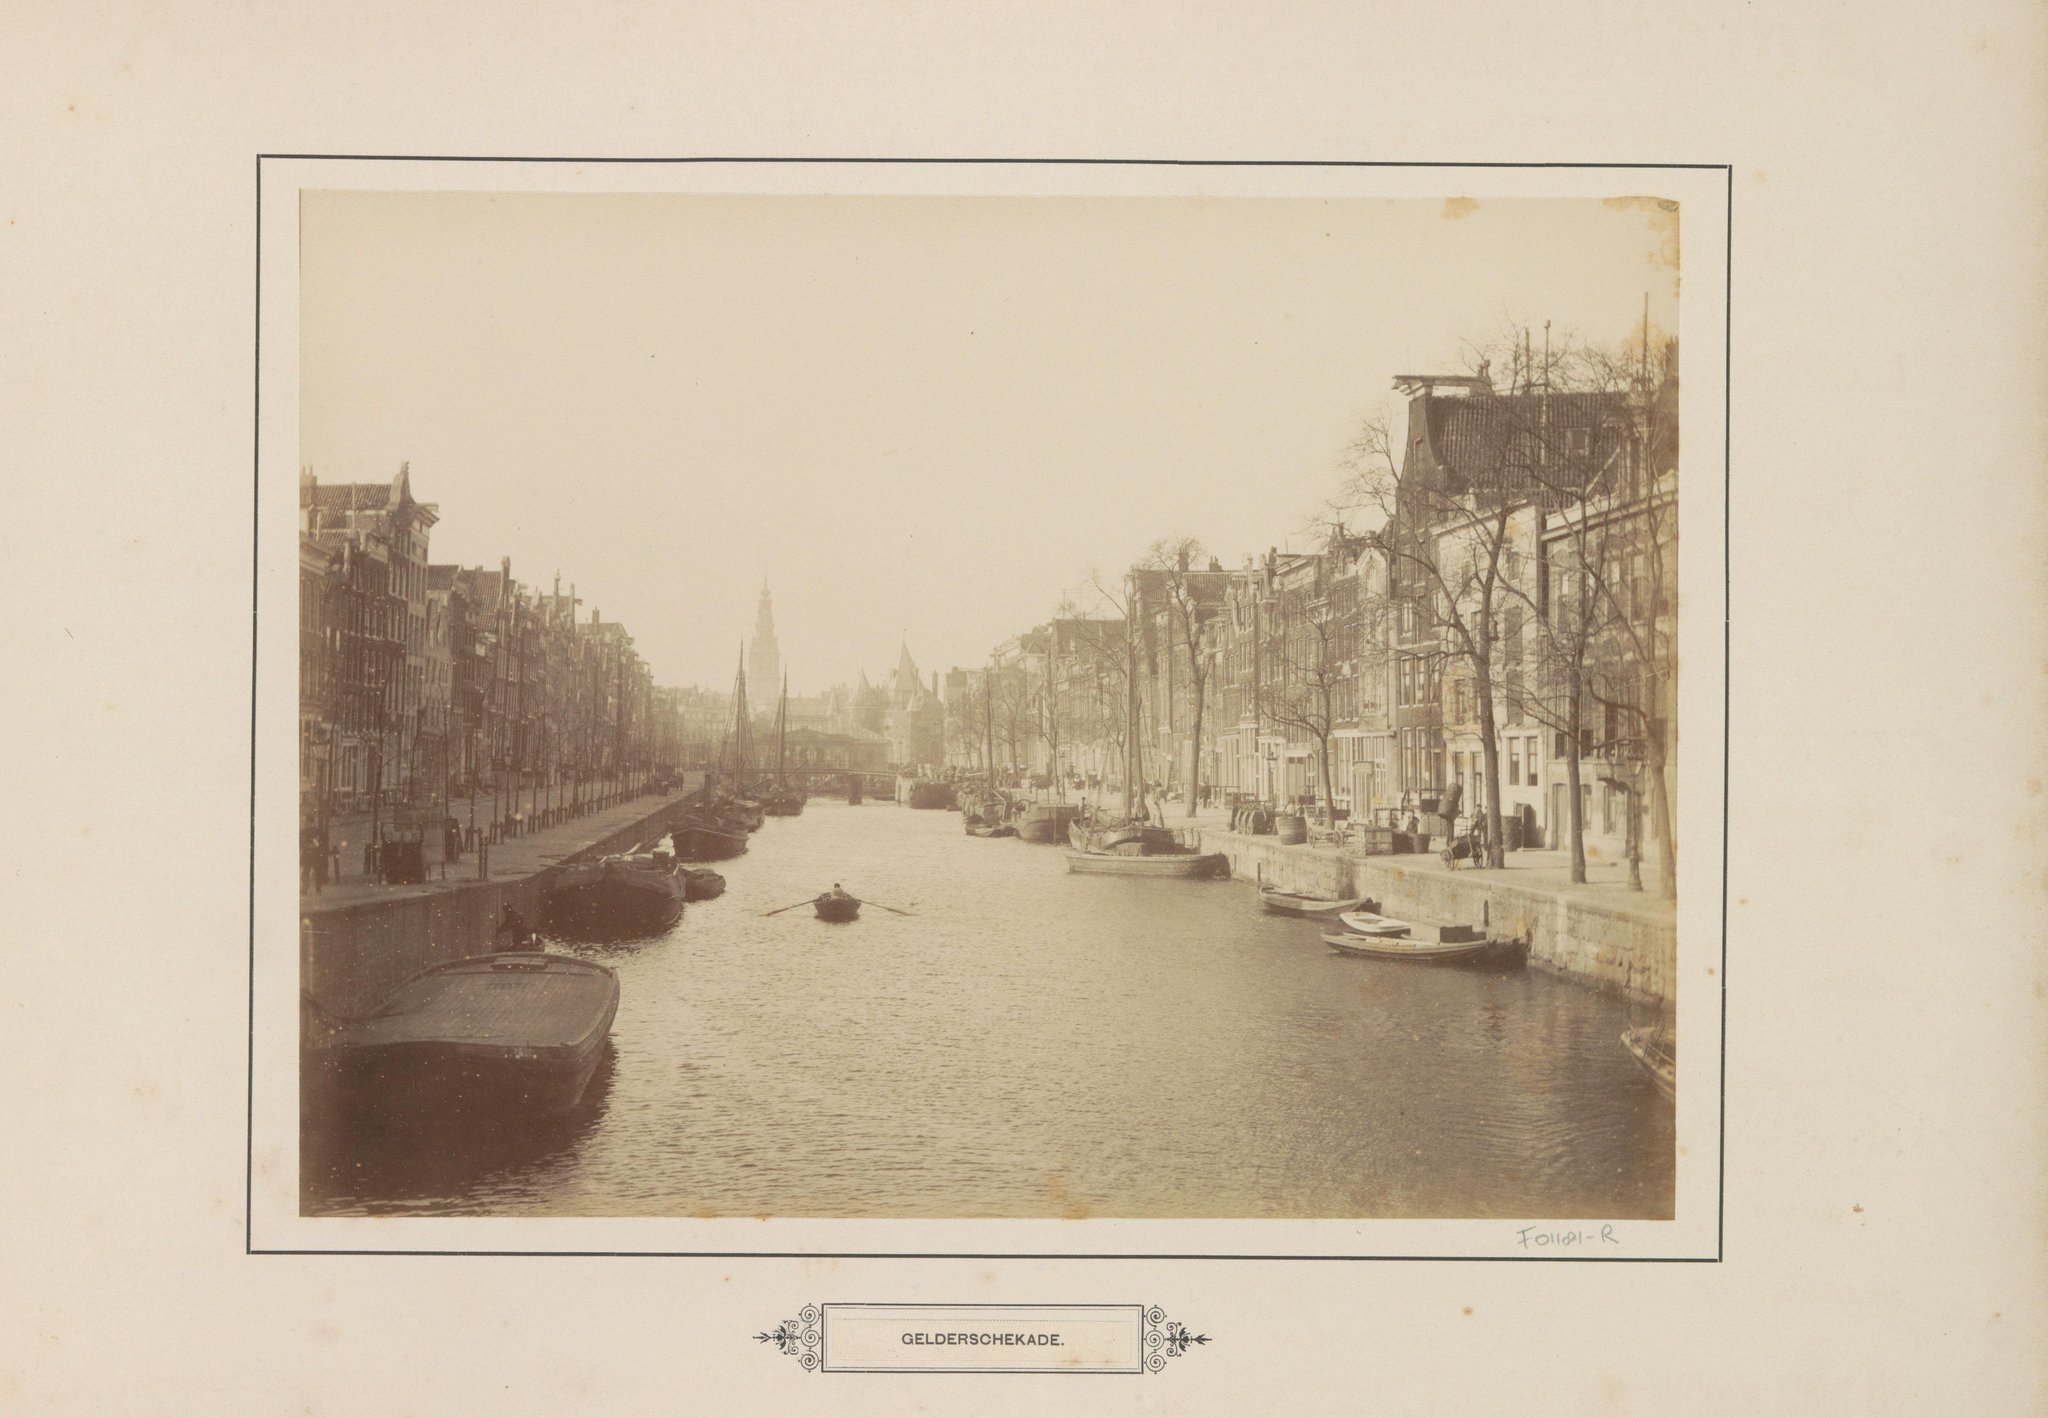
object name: photograph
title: Gelderschekade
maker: Anonymous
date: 1880-1895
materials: photographic support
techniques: albumen print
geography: amsterdam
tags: canal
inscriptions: inscription: ‘Hendrik Groote. 43. Kalverstraat 43. Eastman Kodak Agency Darkroom at disposal.’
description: Onderdeel van Fotoalbum met opnames van het centrum van Amsterdam en reclameteksten voor winkels en bedrijven.